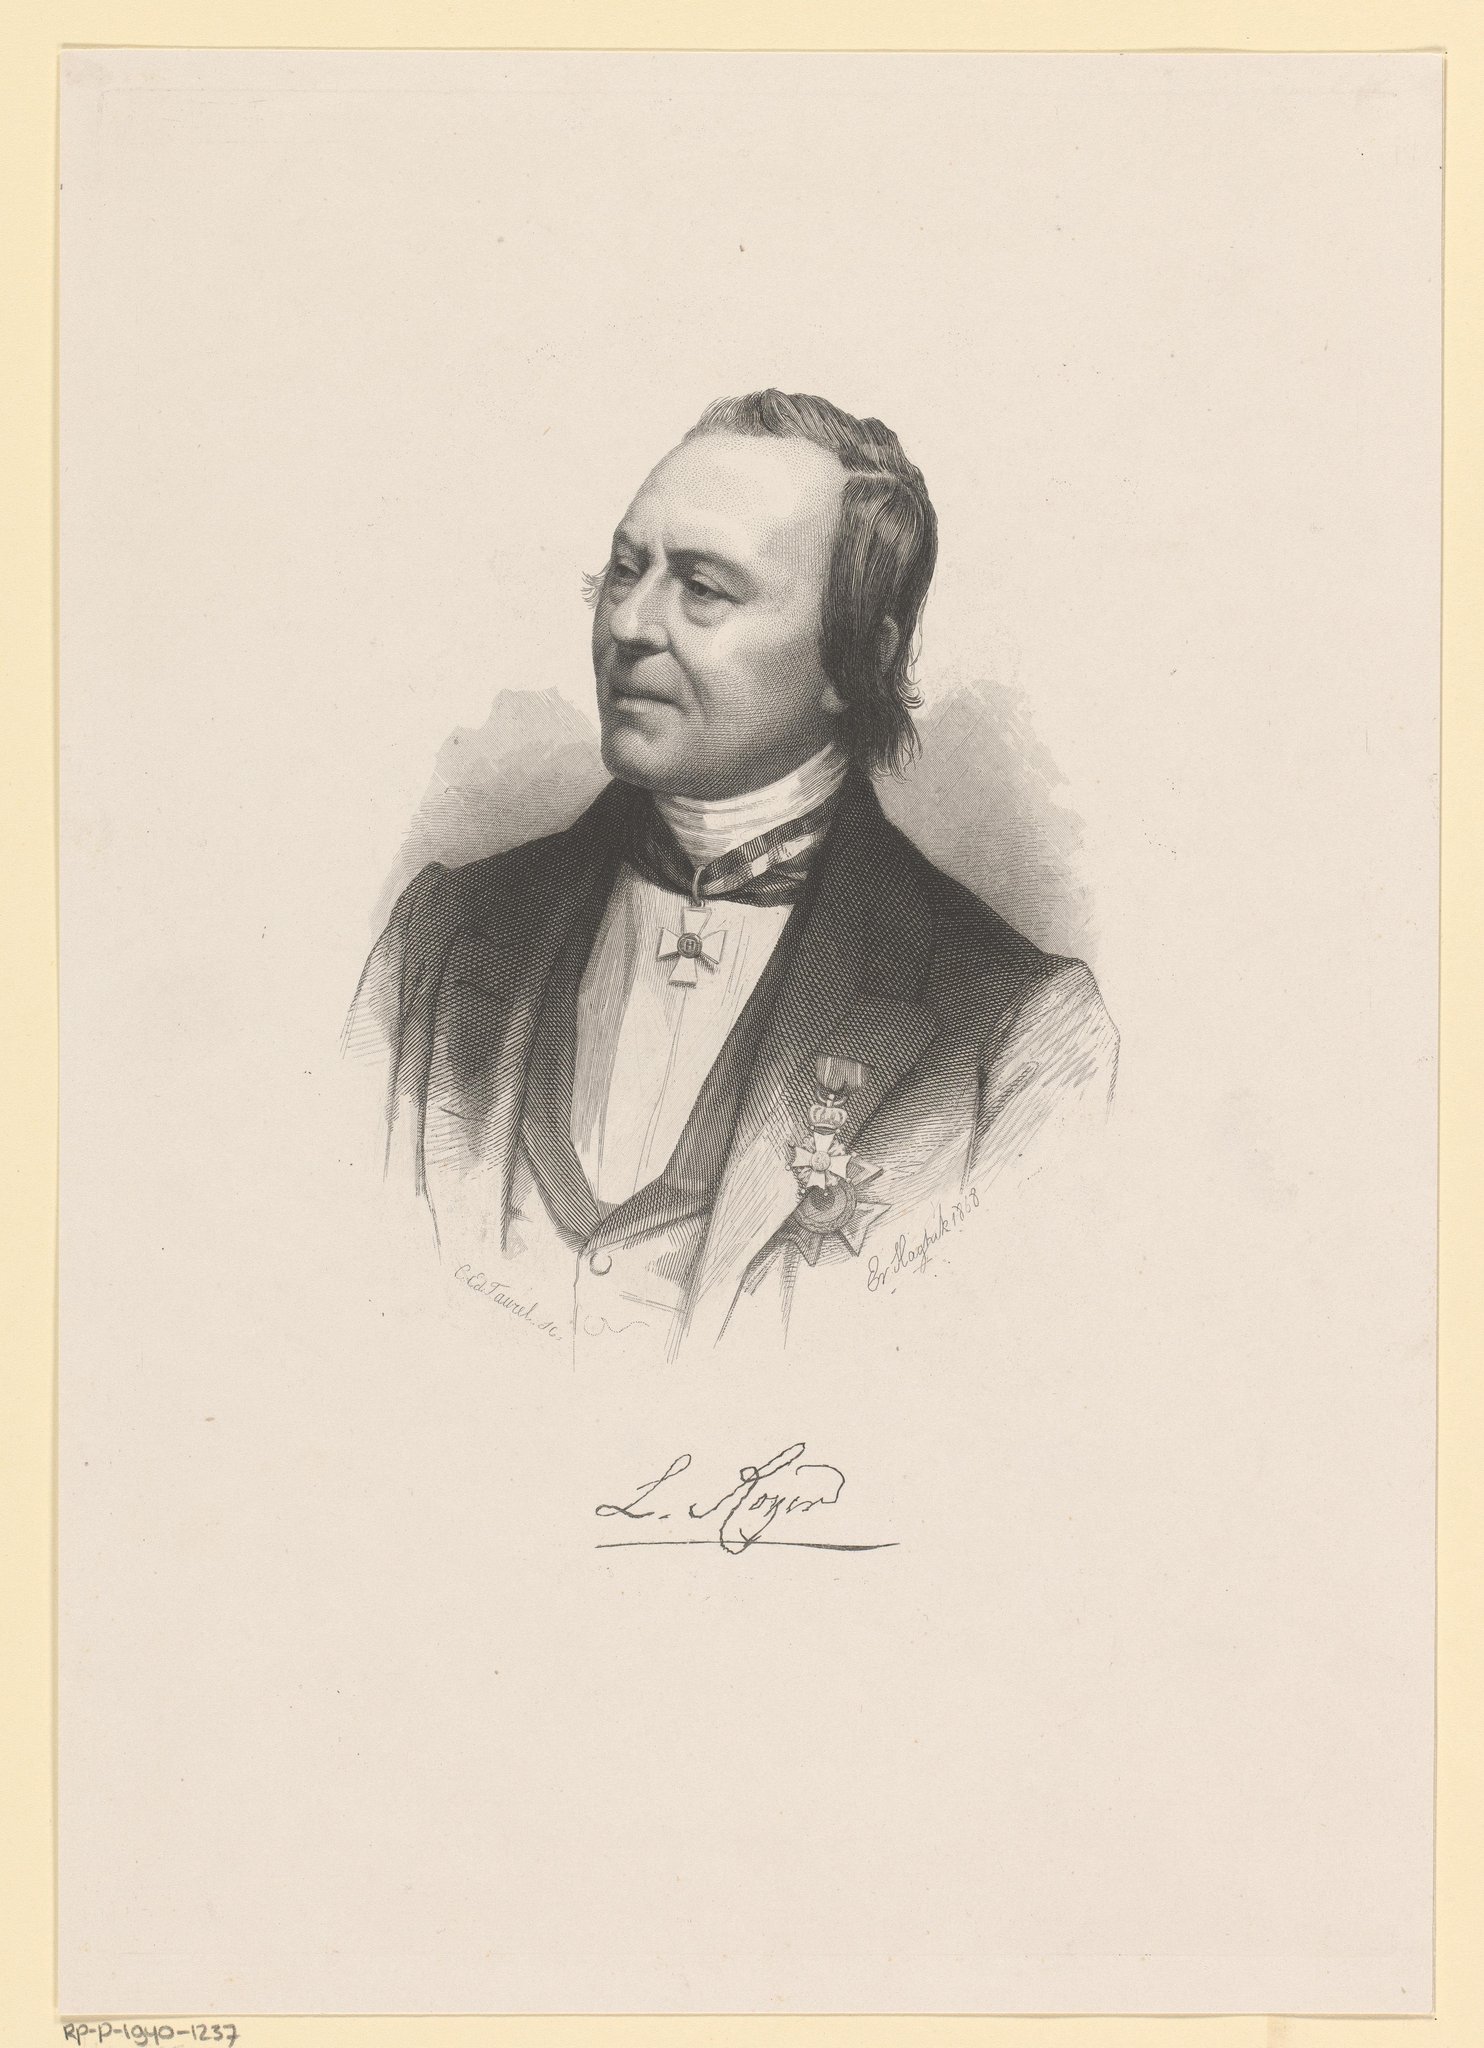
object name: print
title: Portret van Louis Royer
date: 1868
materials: paper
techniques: engraving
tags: mechelen, amsterdam, draughtsman, sculptor, louis royer, historical persons, portrait, self-portrait of artist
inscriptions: collector's mark: Lugt 2228, collector's mark: Lugt 2760